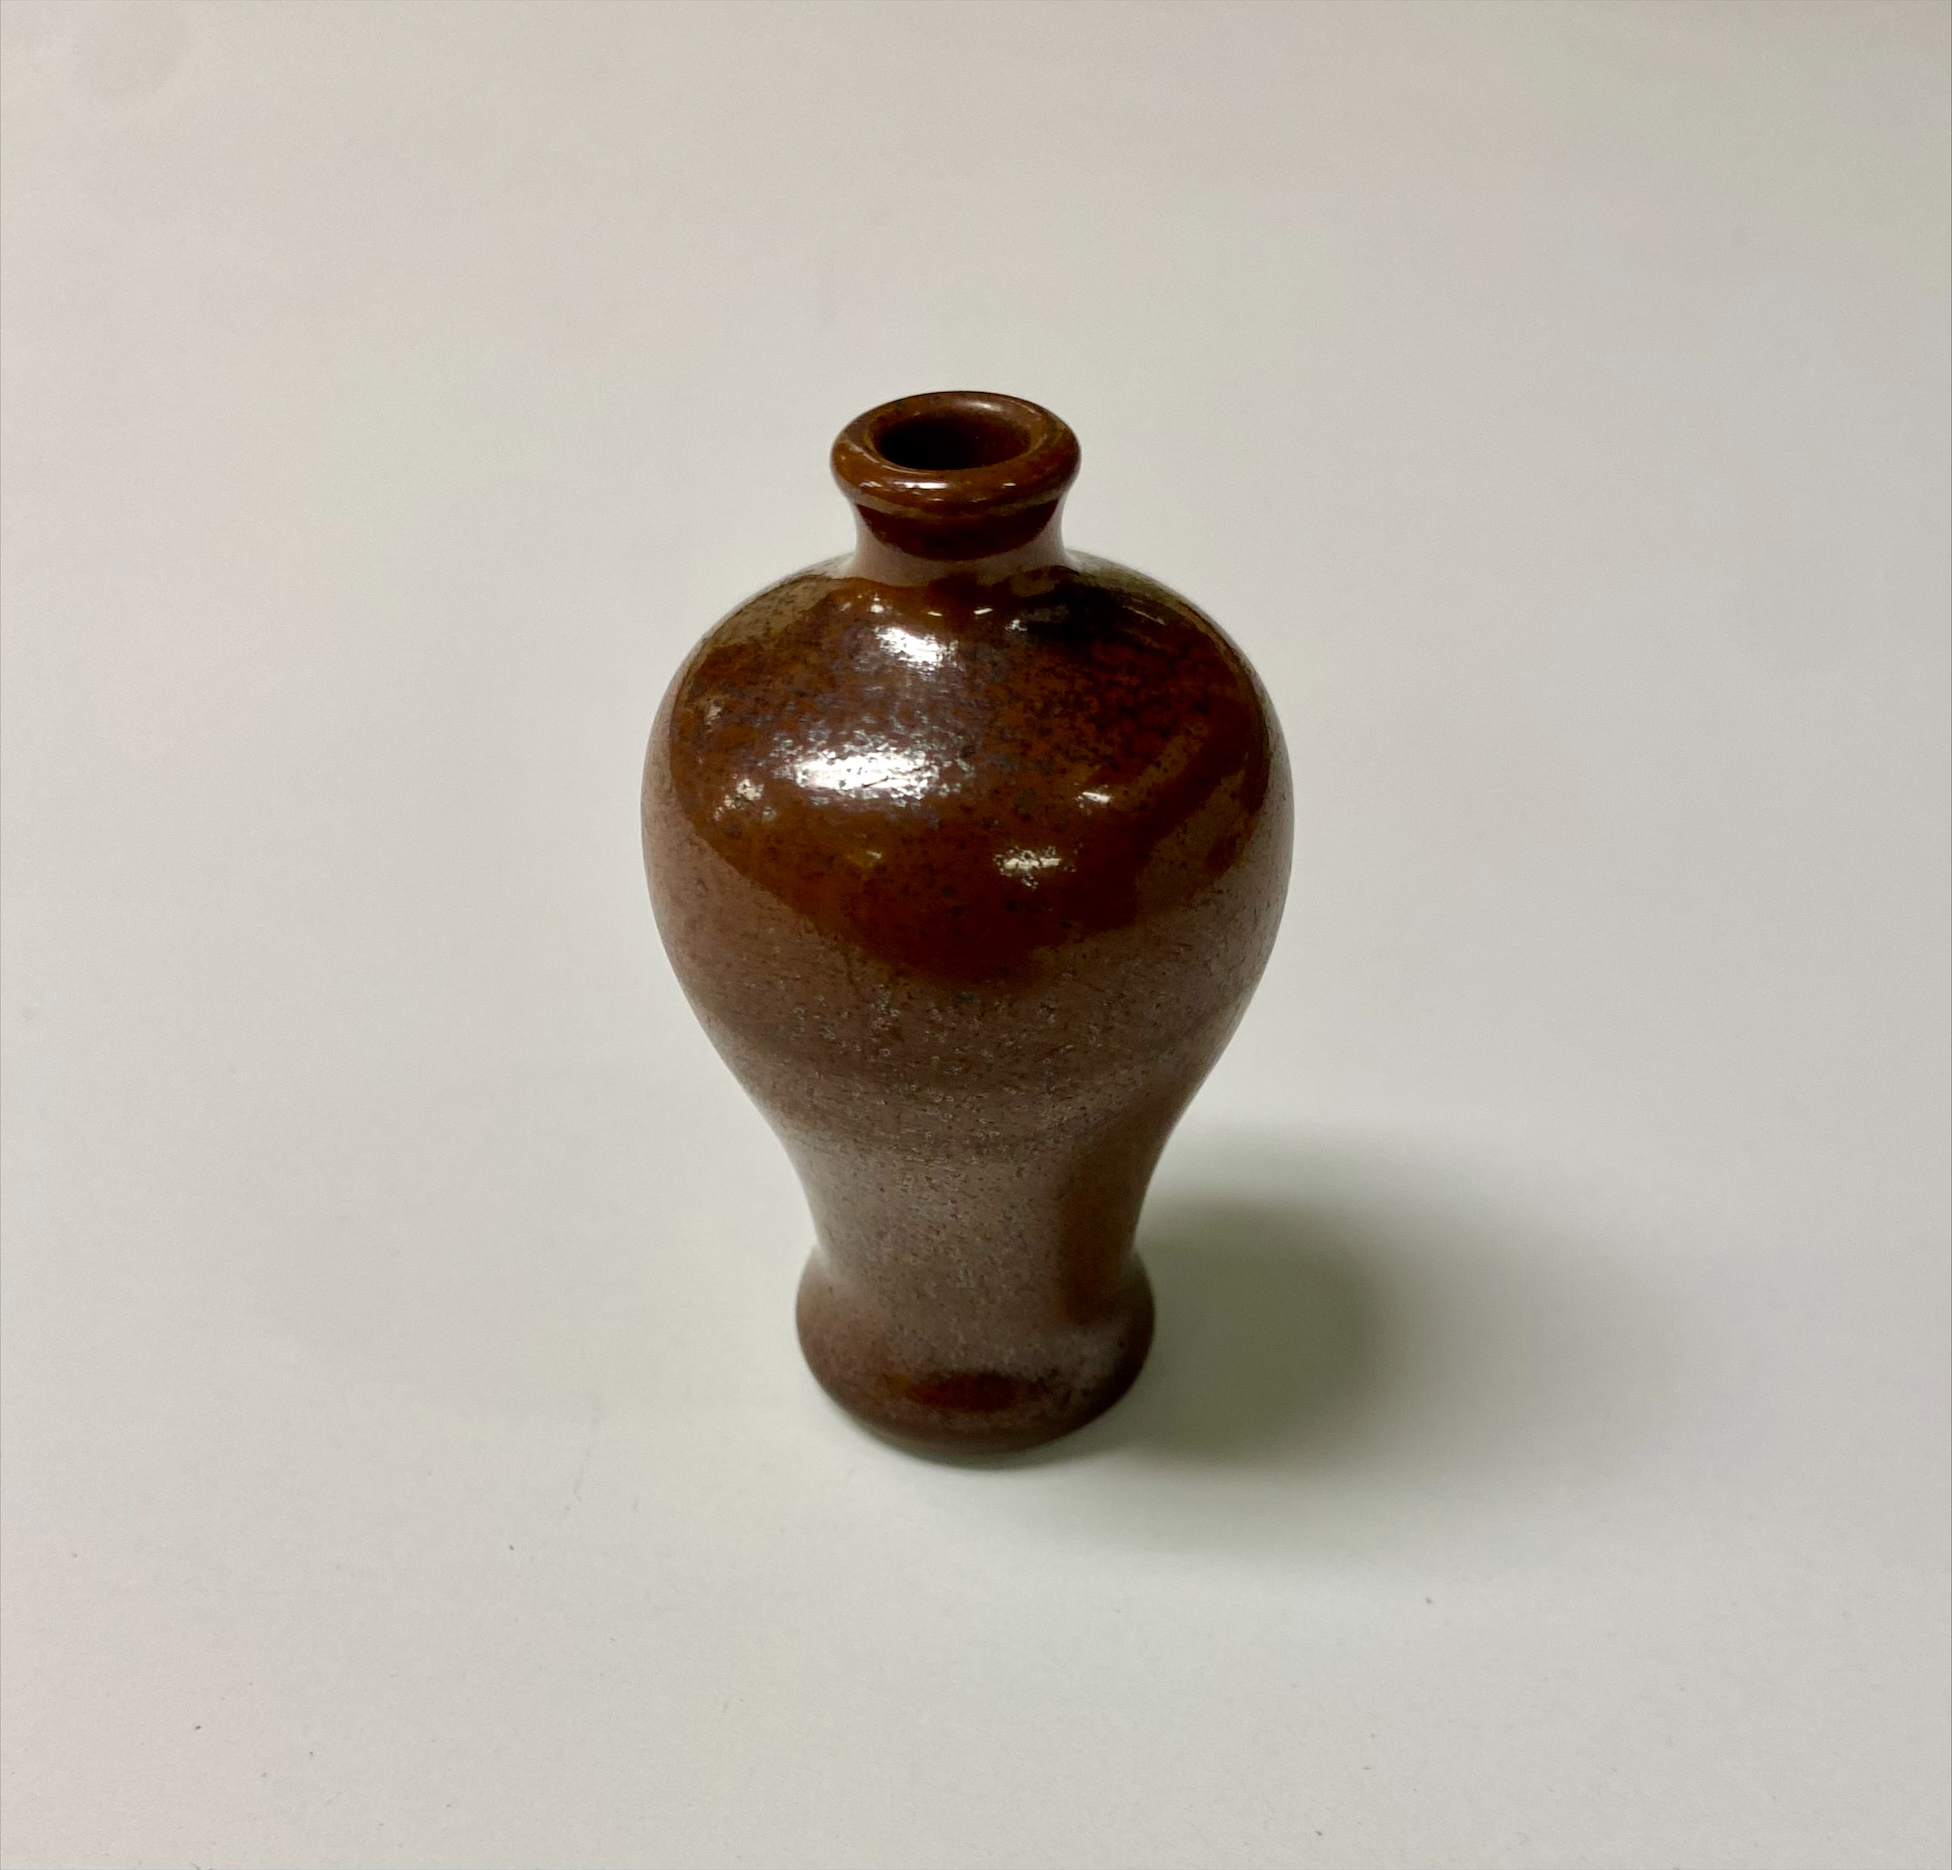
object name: vase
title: Minature meiping vase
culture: chinese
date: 1701-1800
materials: glaze, iron, porcelain